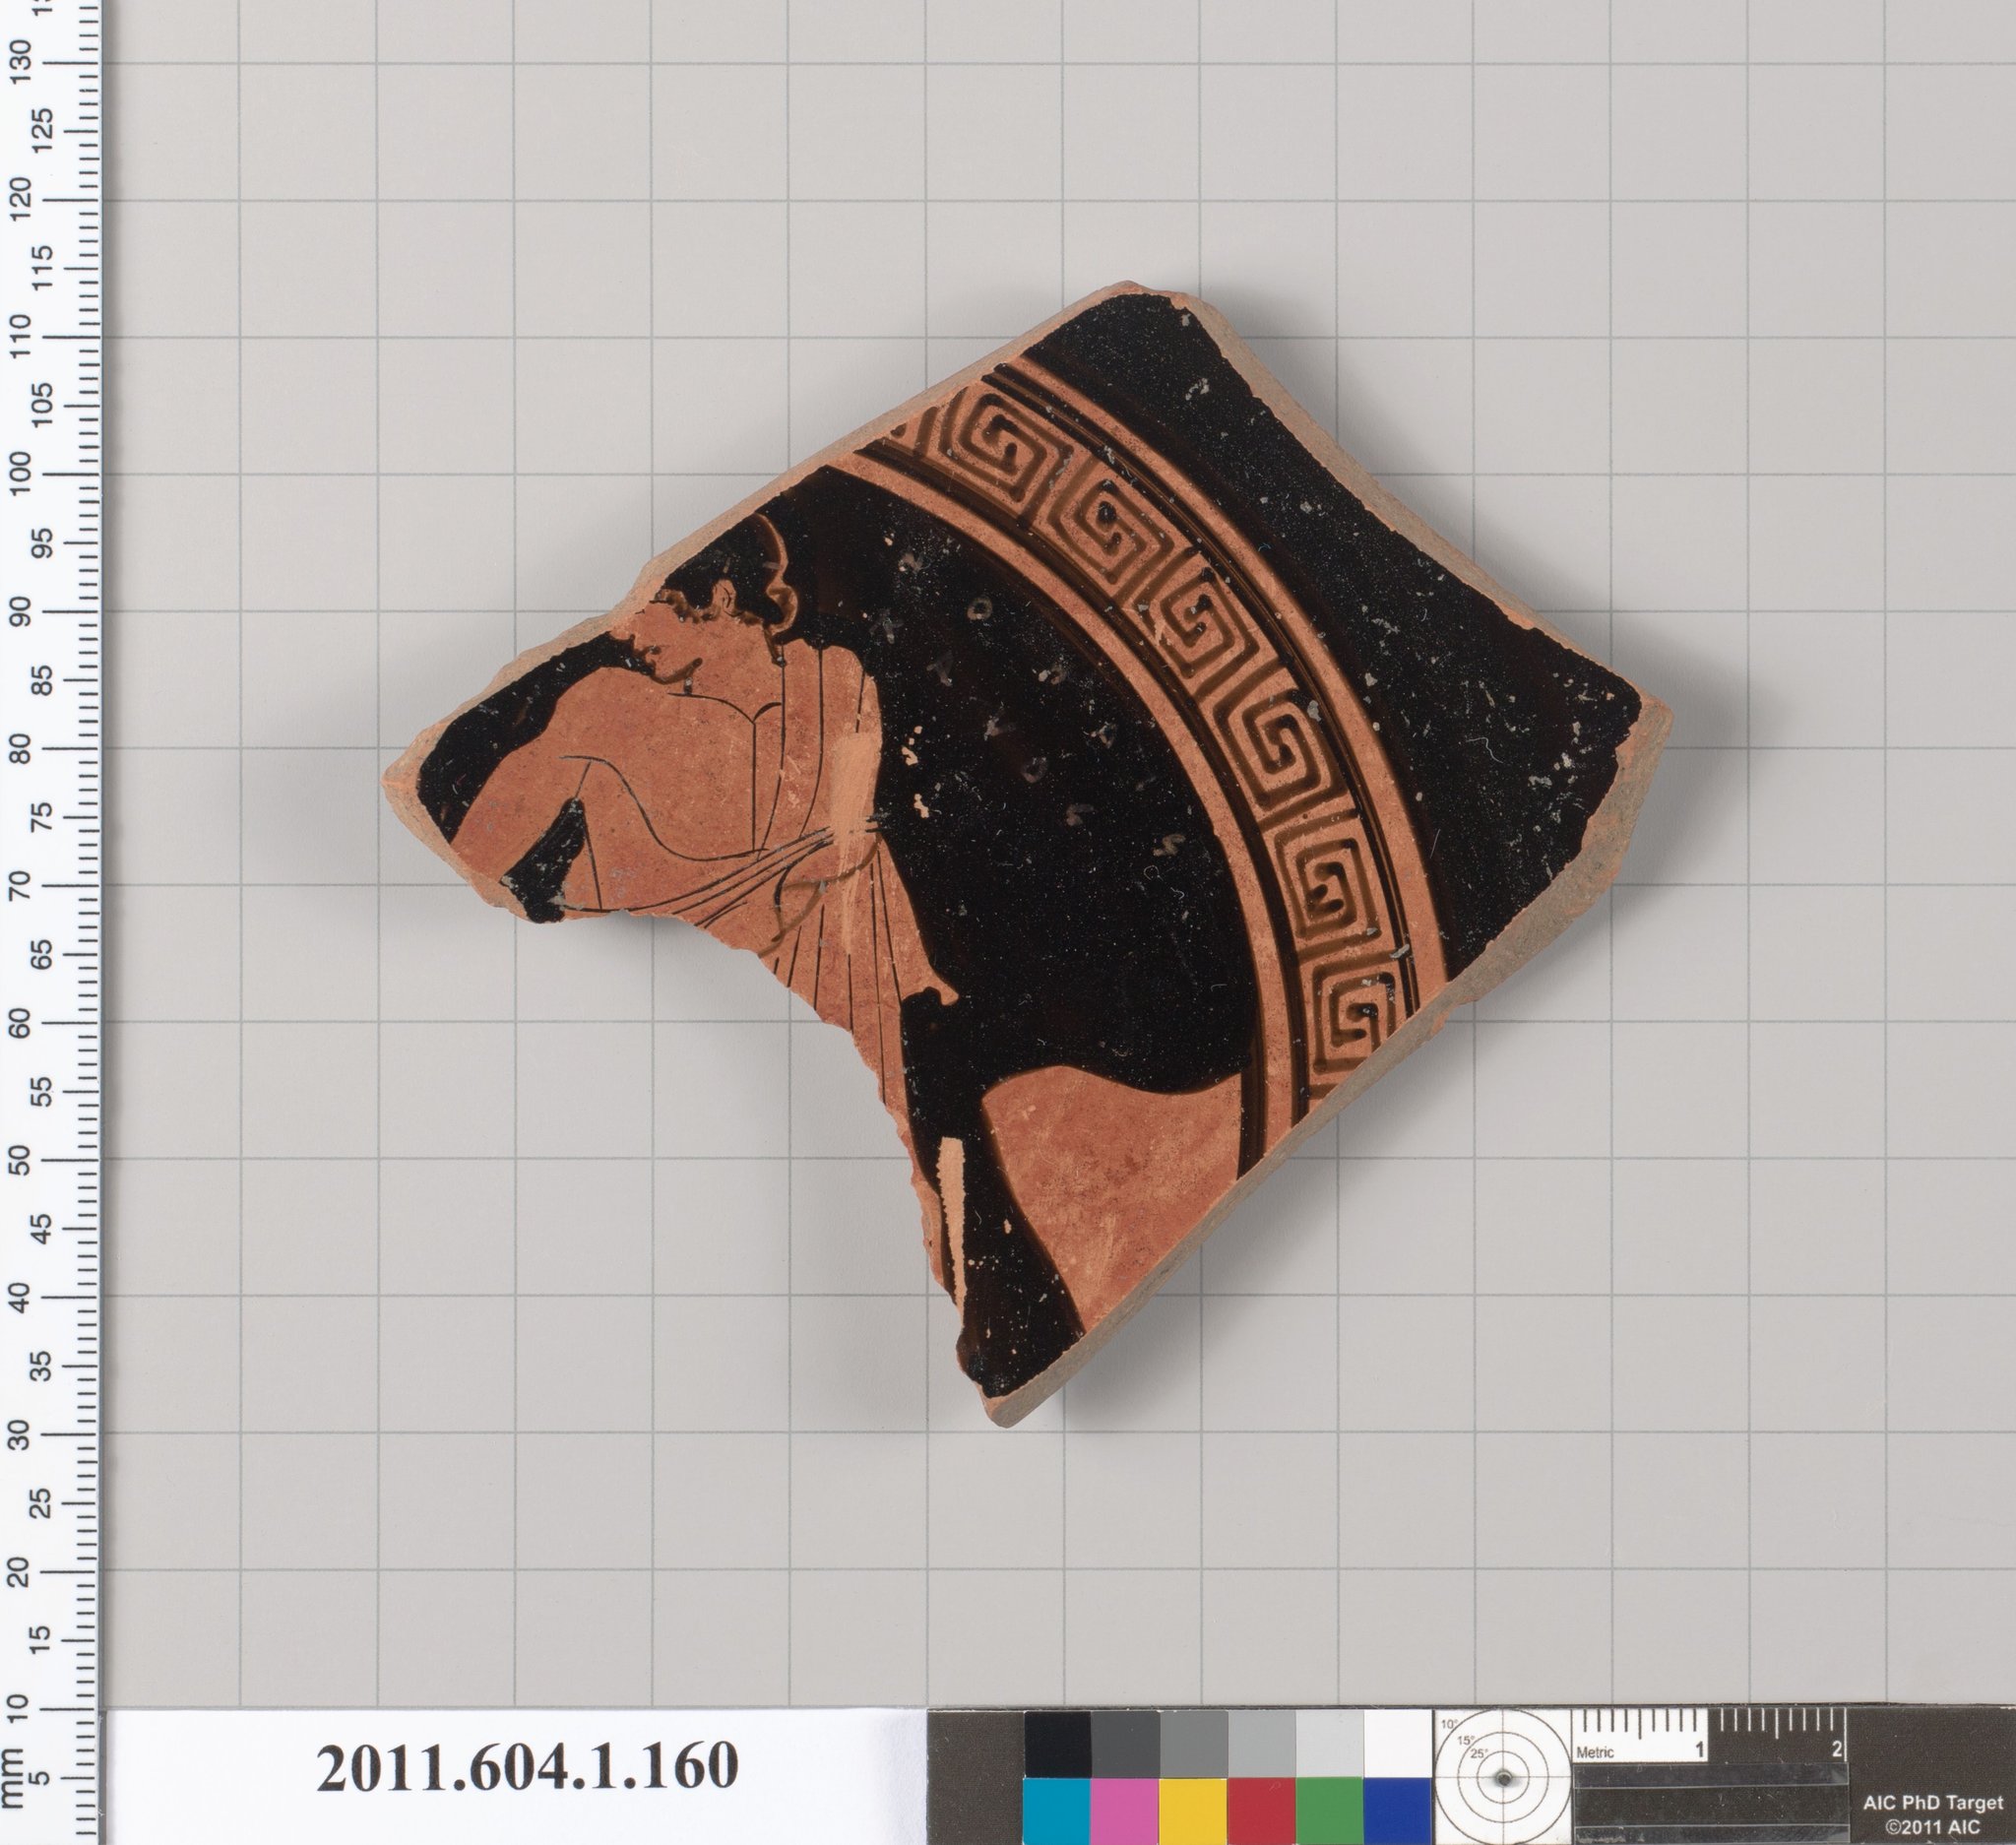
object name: kylix fragment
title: Terracotta fragment of a kylix (drinking cup)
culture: greek, attic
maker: penthesilea painter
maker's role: artist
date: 470-450 BCE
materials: terracotta